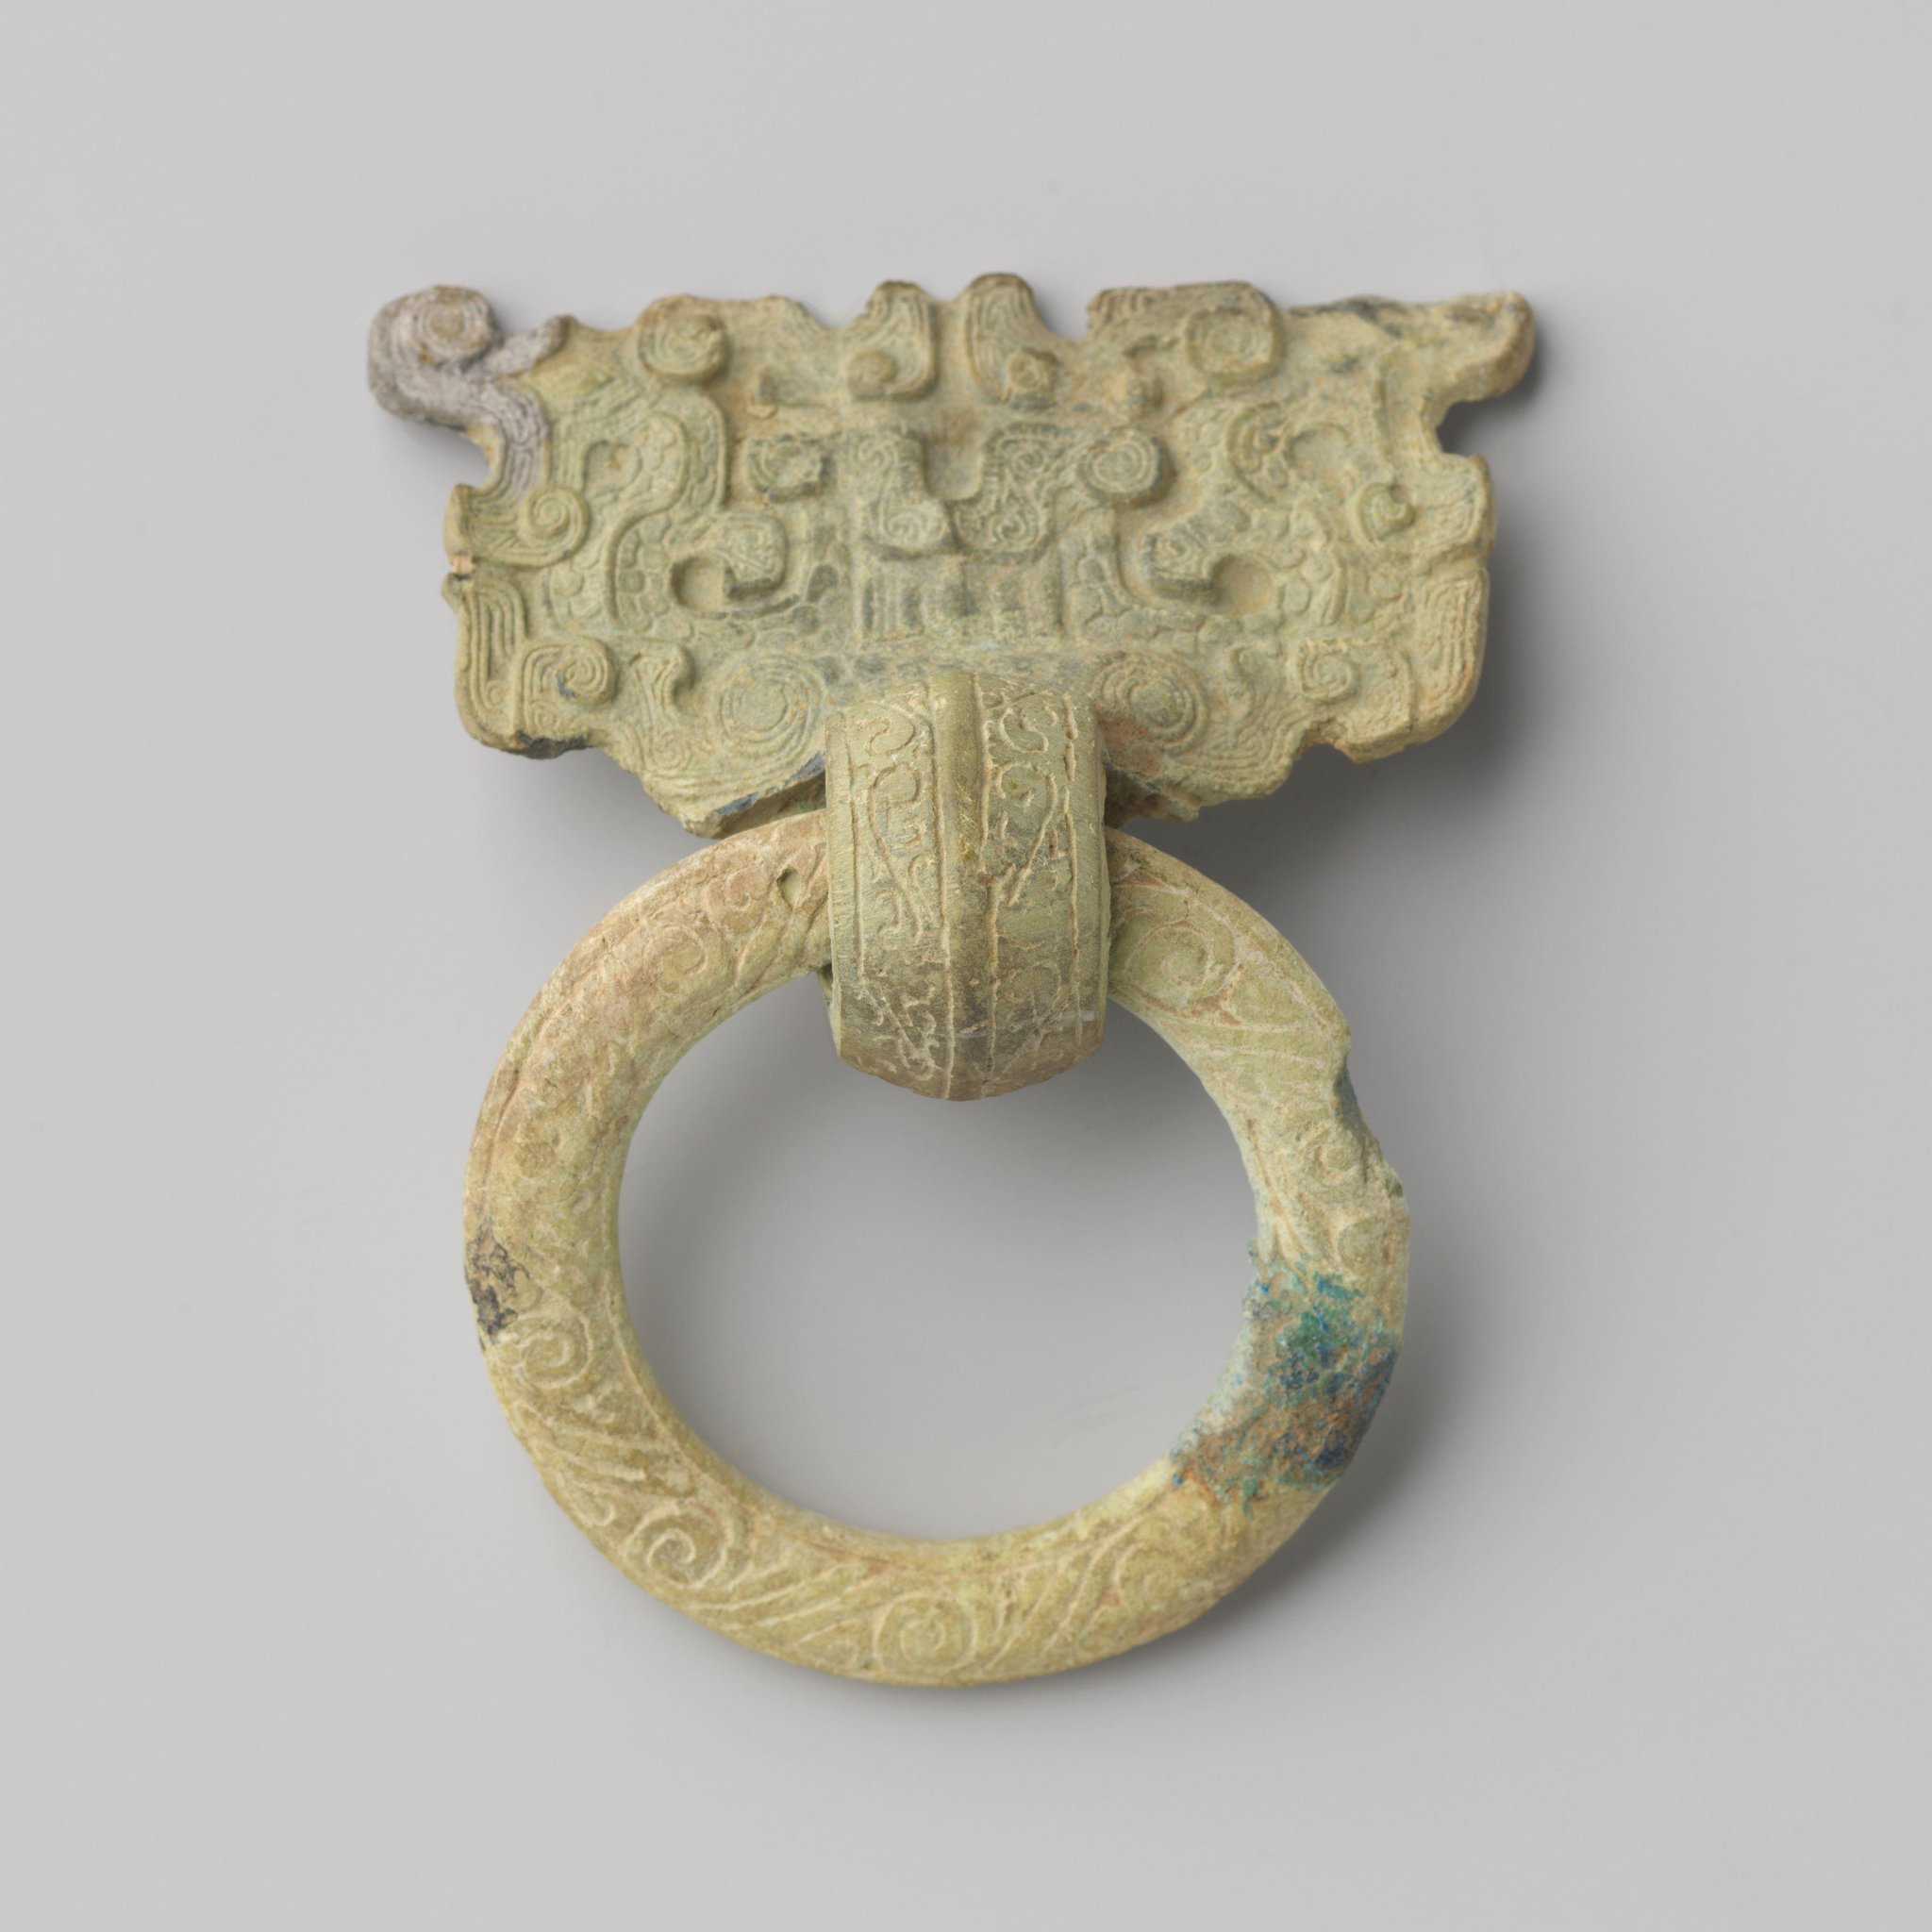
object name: hengsel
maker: Anonymous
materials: bronze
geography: china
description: Handle showing entwined stylized snakes. China. Early Eastern Zhou period (722 - 481 BC). Bronze.